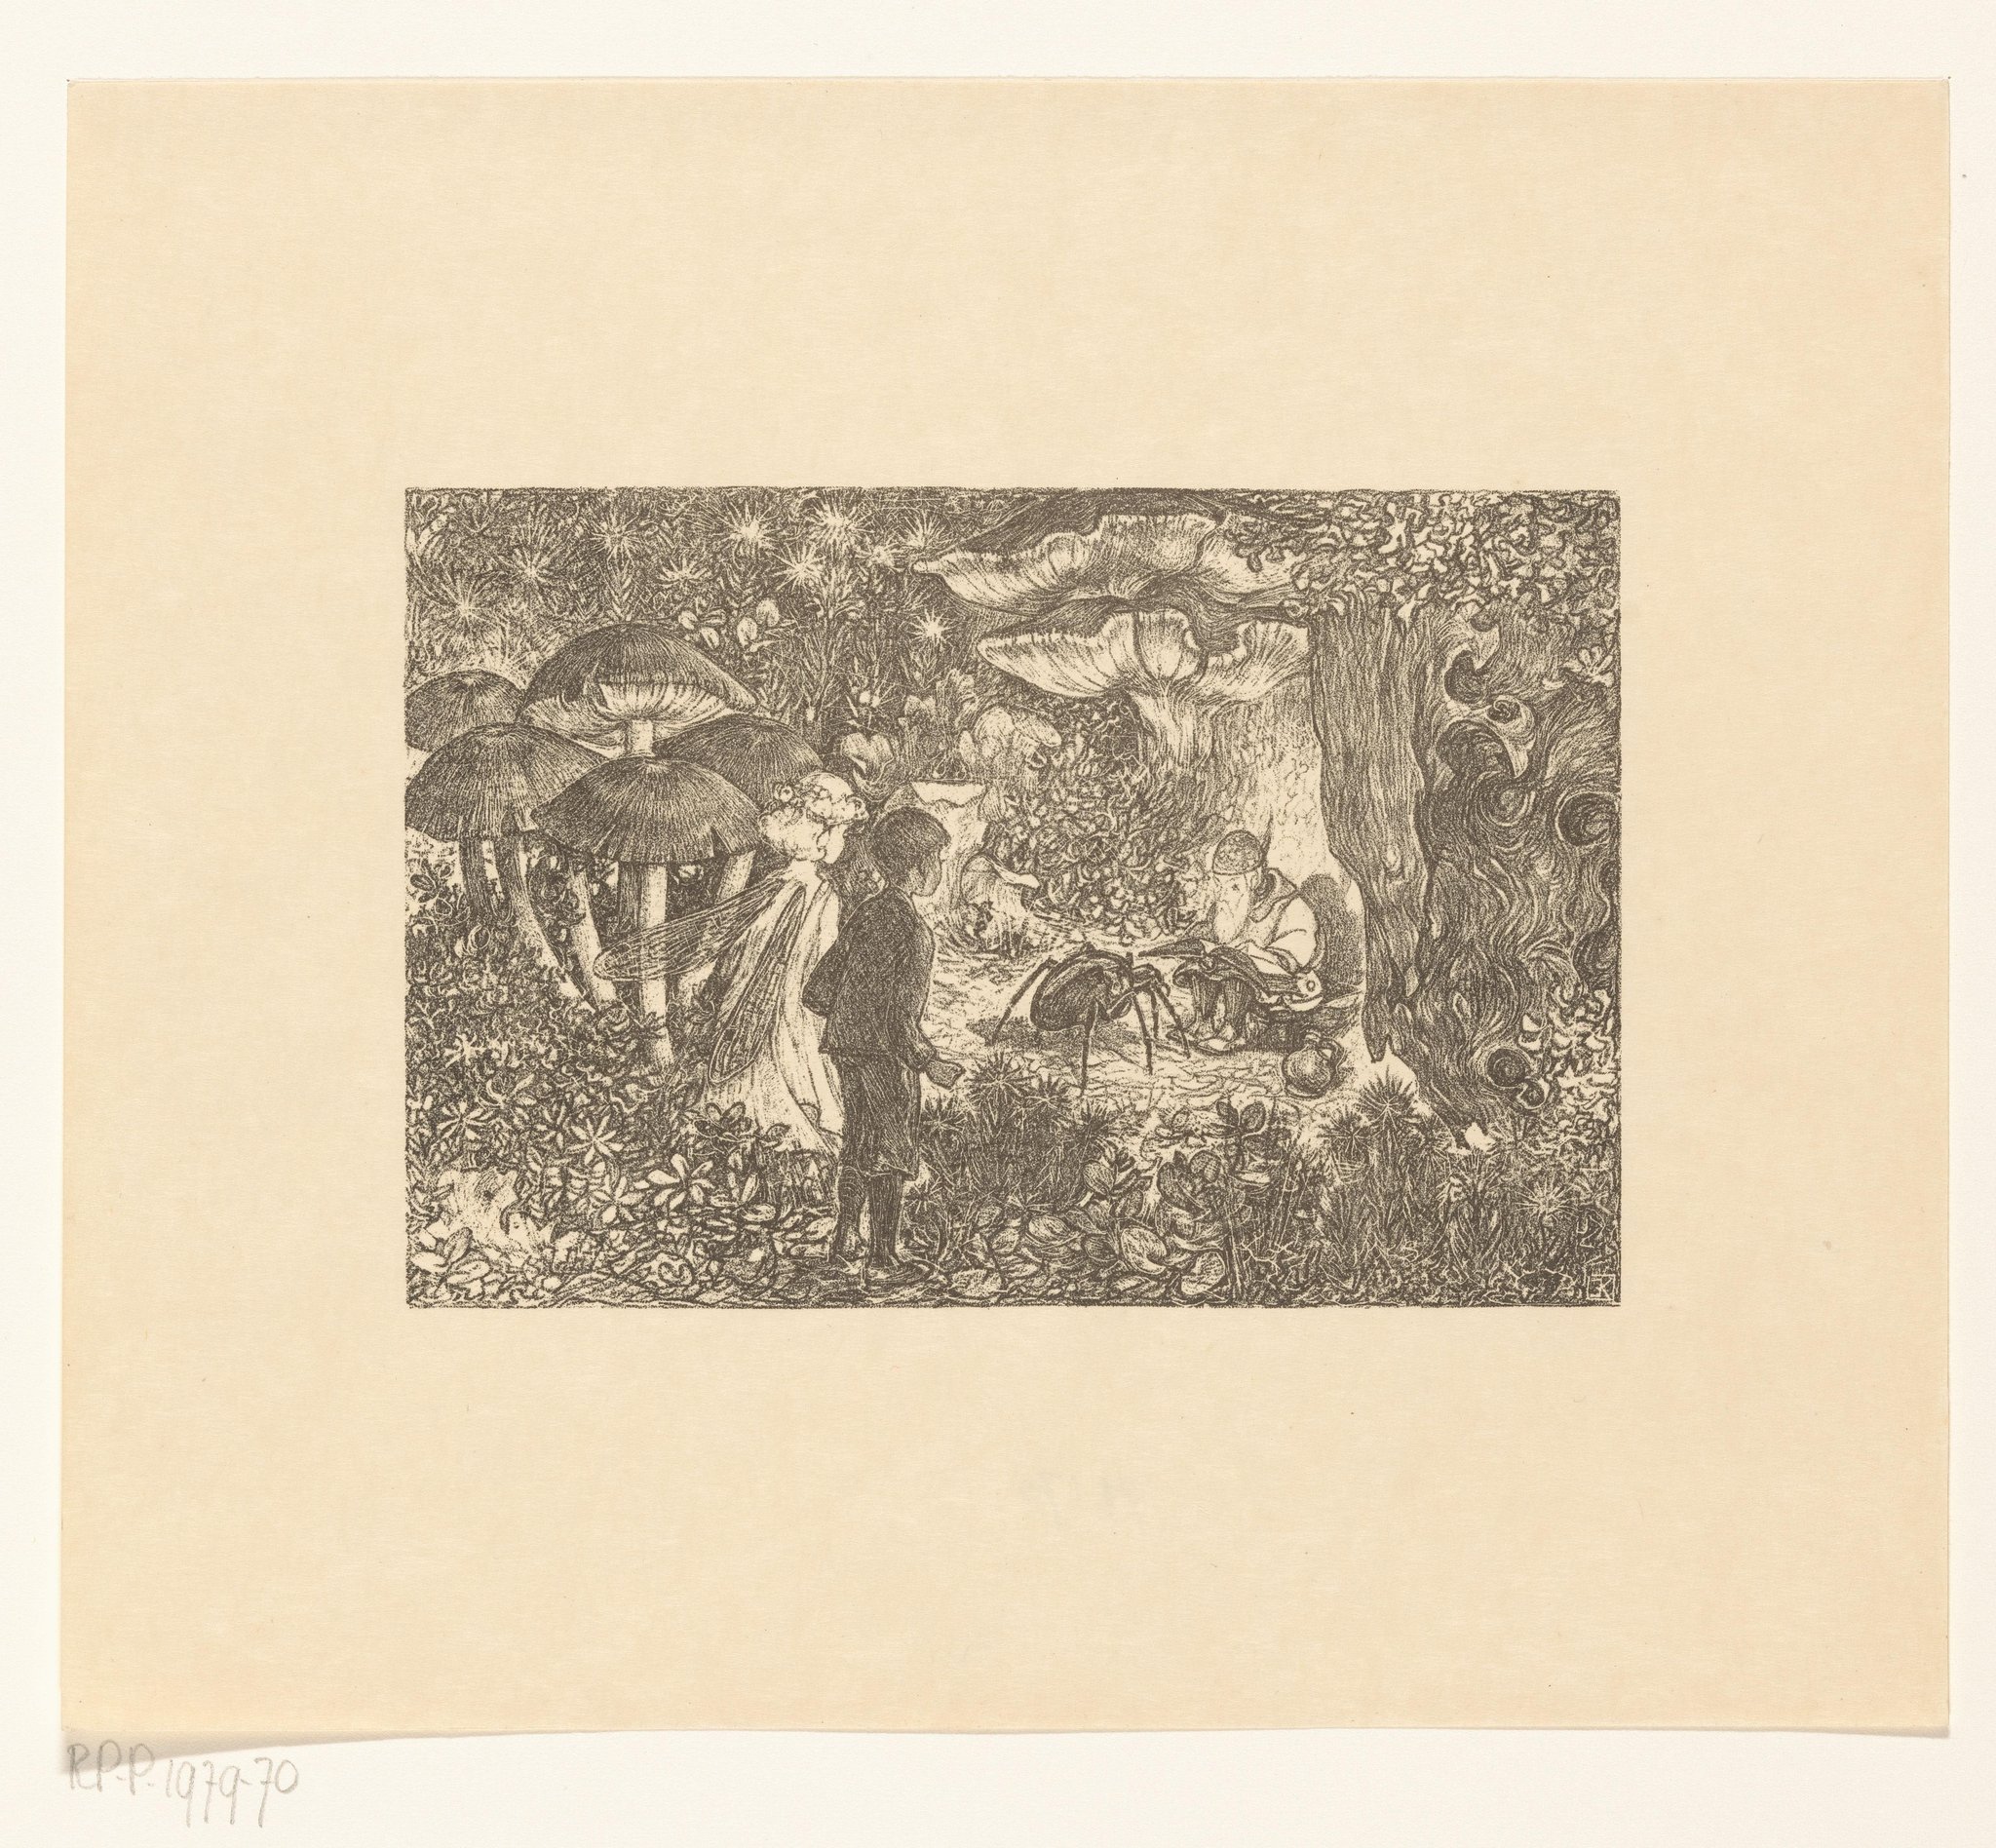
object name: boekillustratie ontwerp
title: Johannes en Windekind op bezoek bij de kabouter Wistik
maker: edzard koning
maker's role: draughtsman, print maker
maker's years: 1869-1954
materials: paper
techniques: lithograph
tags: spirit of the earth, gnome, troll, spiders, mushrooms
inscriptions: collector's mark: Lugt 2228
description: Wistik leest een boek in het gezelschap van een spin. Op de achtergrond groeien paddenstoelen.